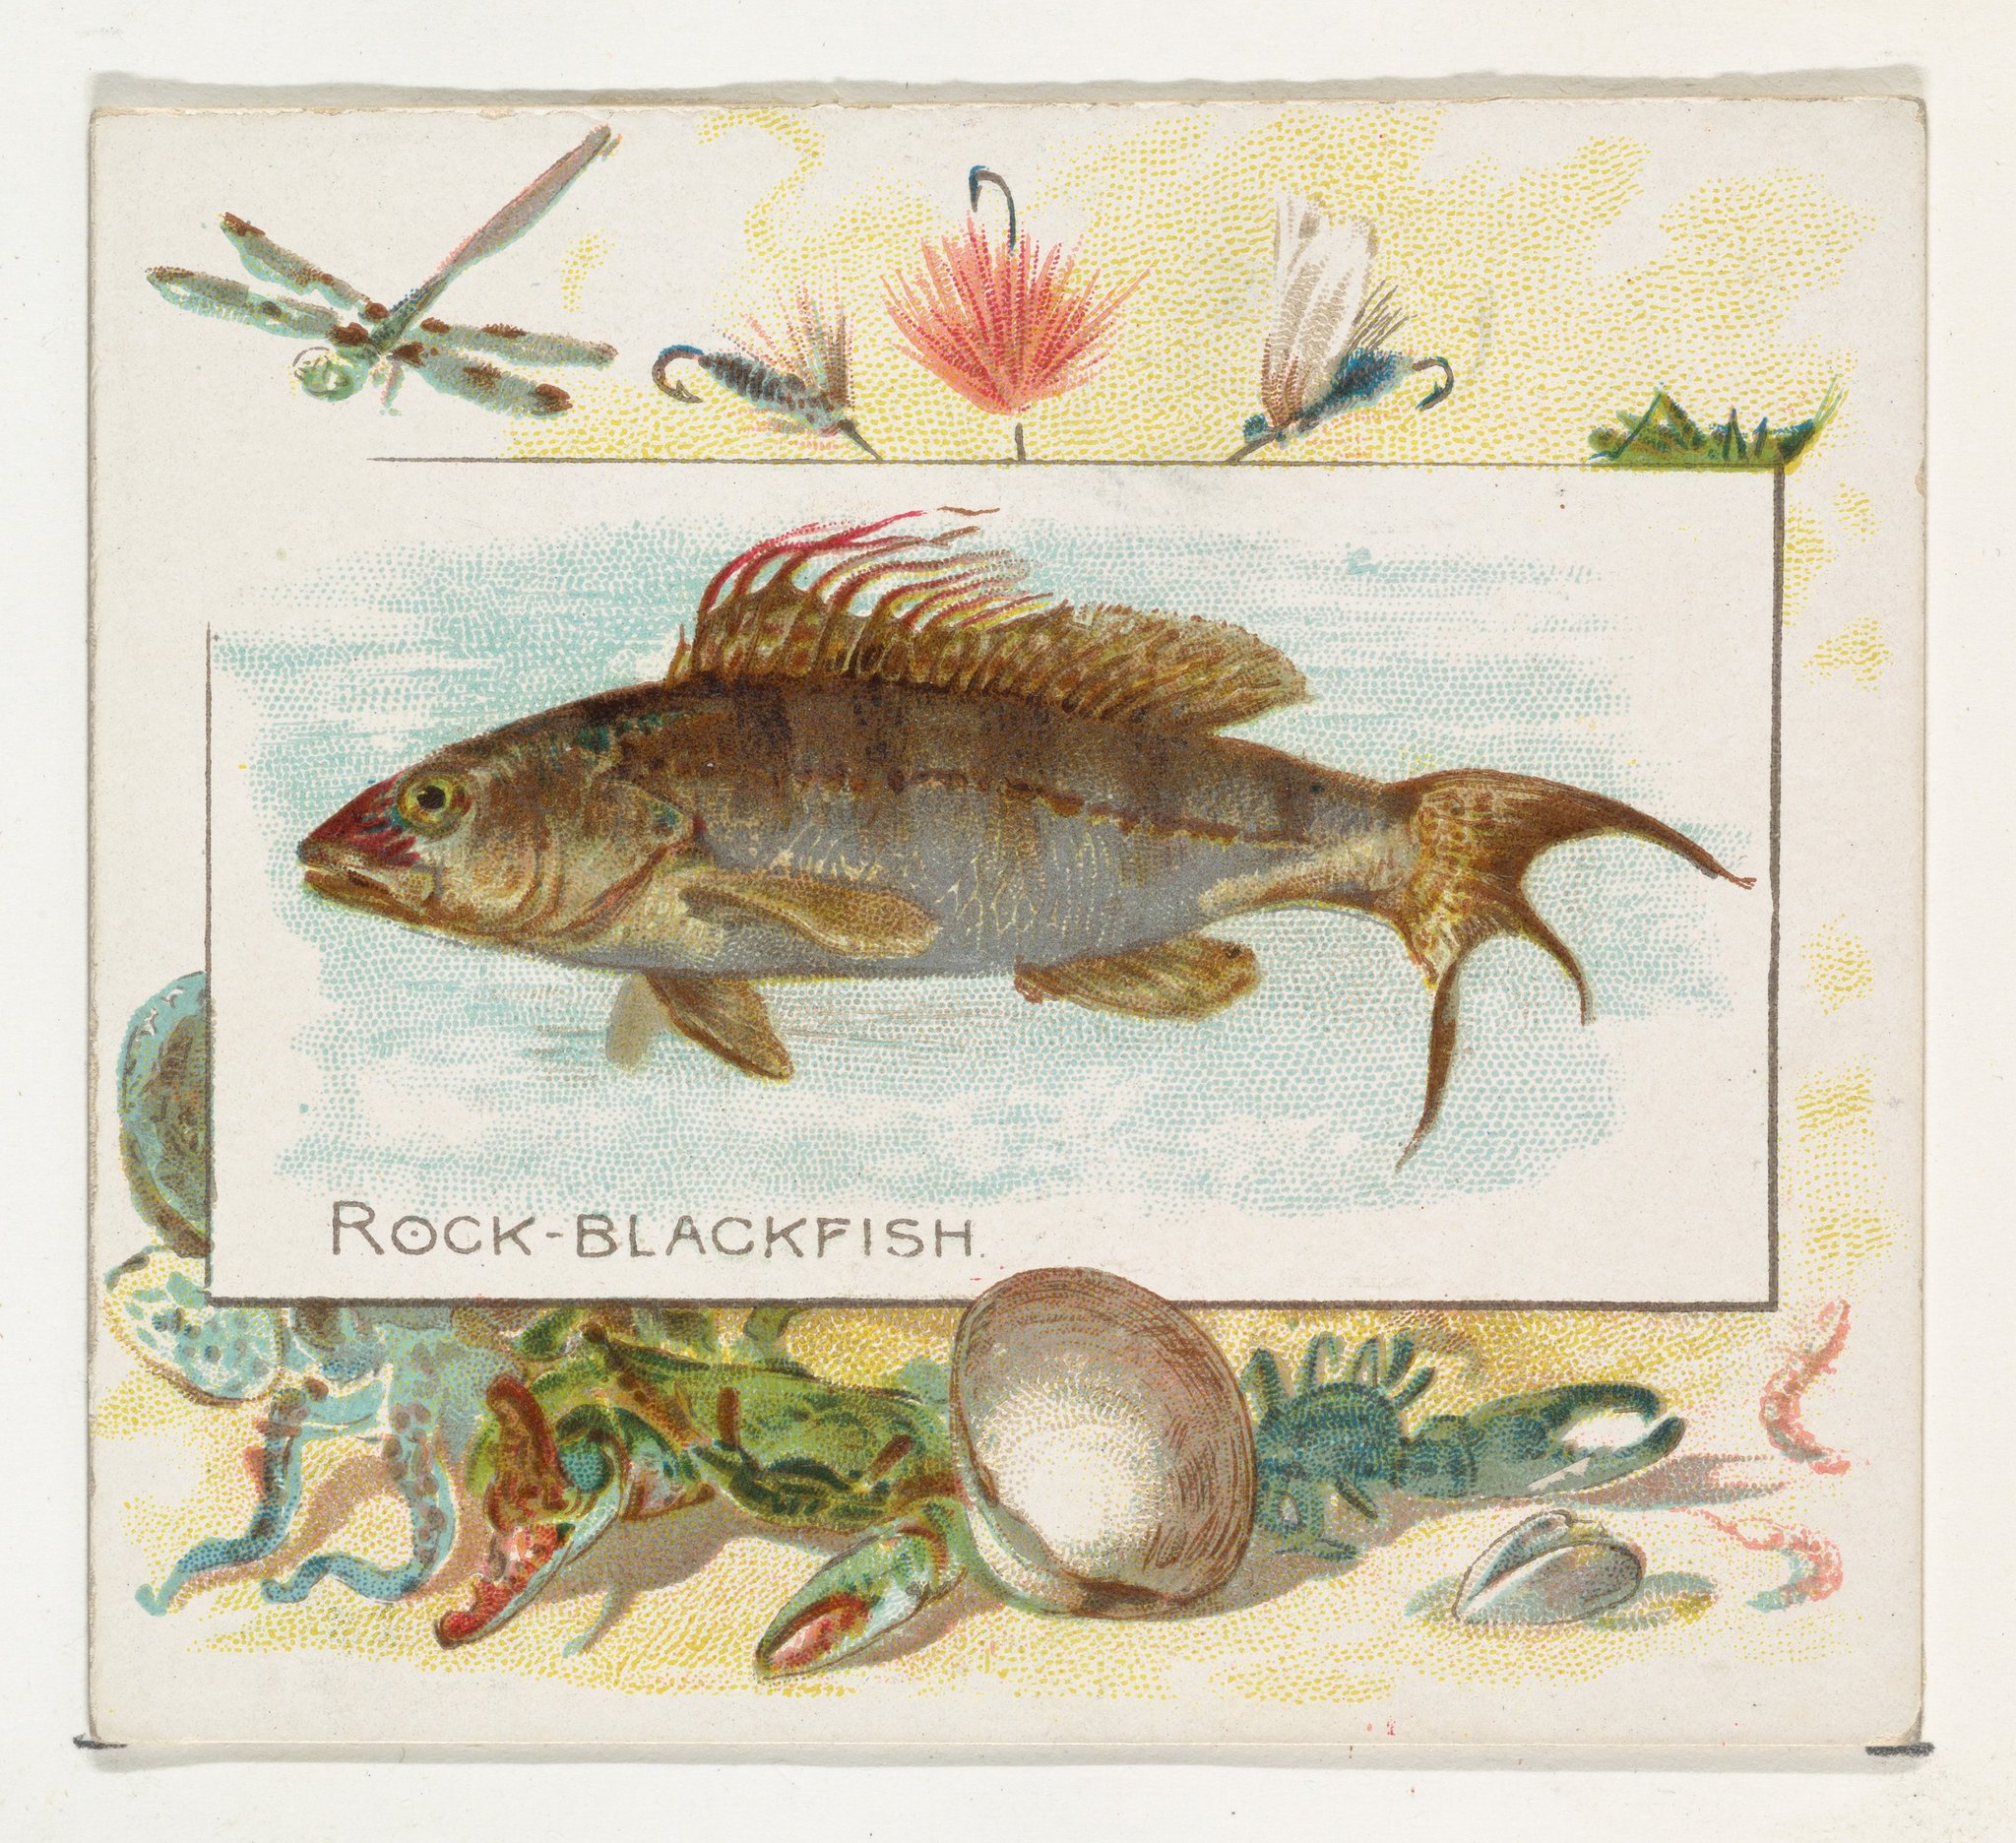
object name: print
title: Rock Blackfish, from Fish from American Waters series (N39) for Allen & Ginter Cigarettes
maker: allen & ginter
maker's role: publisher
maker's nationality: american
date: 1889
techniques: color lithograph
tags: fish